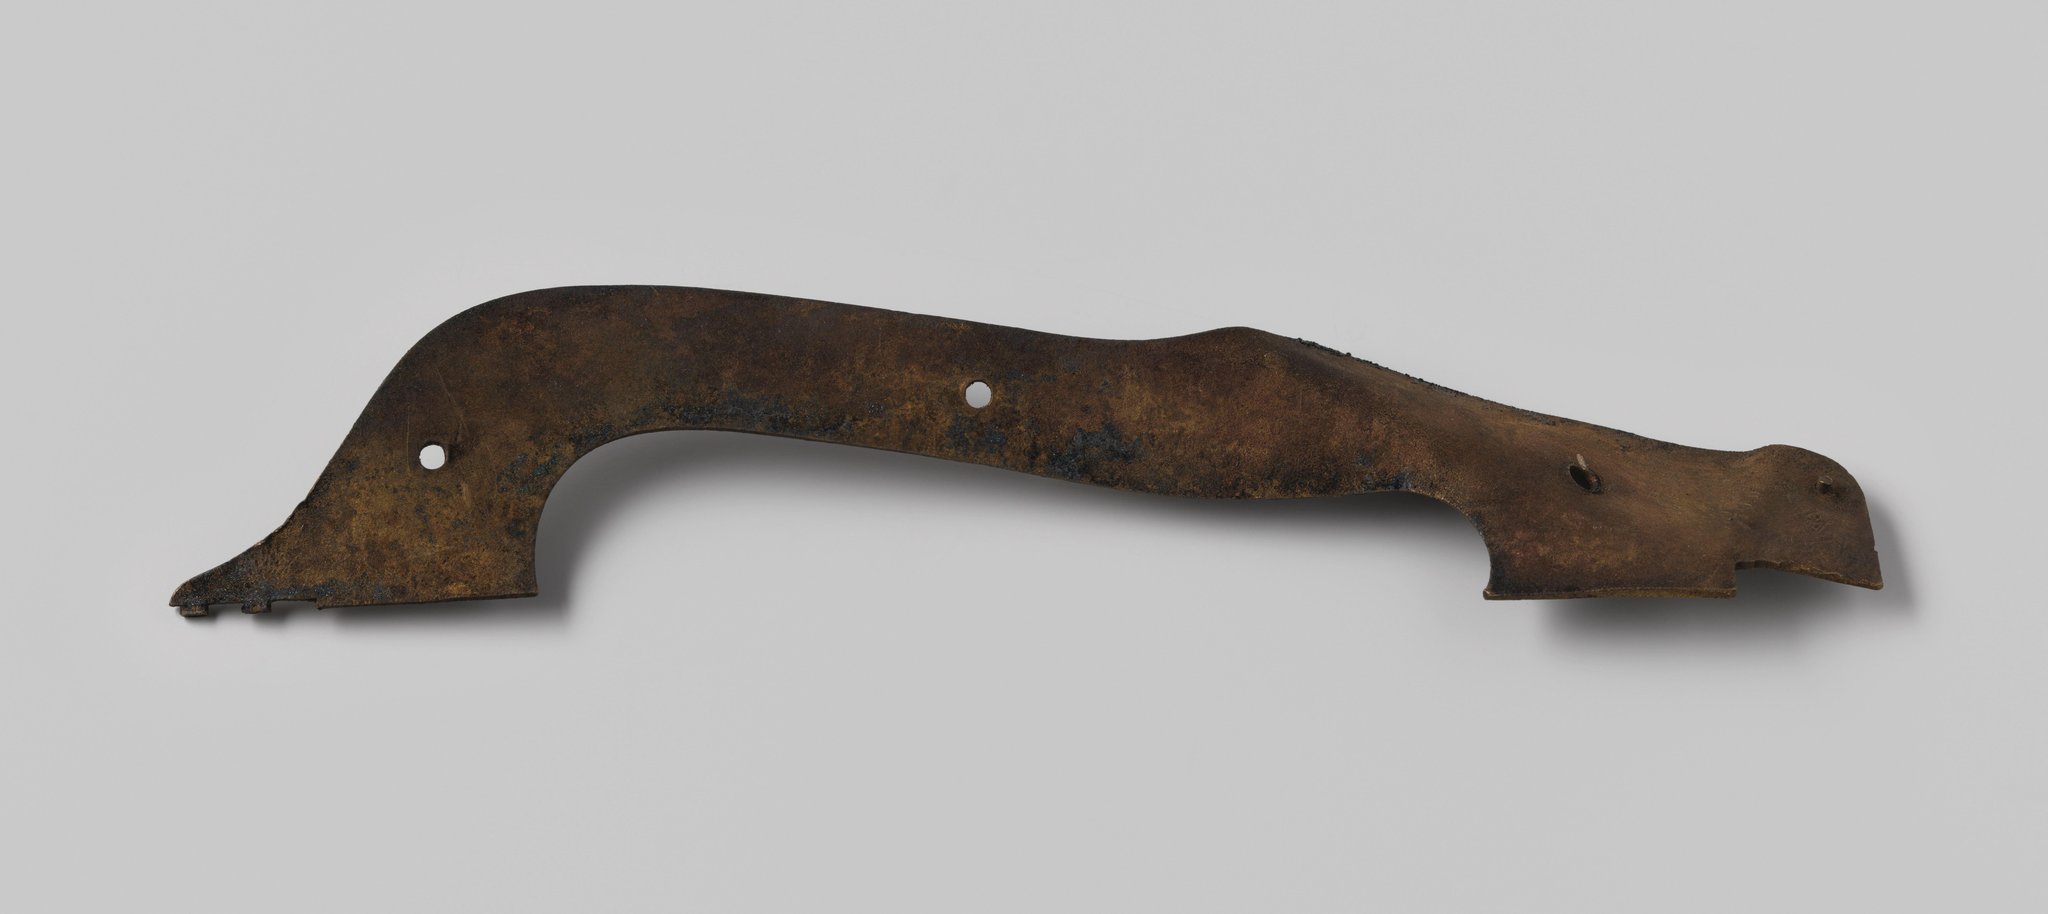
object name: fragment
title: Fragment van koperen beslag uit het wrak van de Oost-Indiëvaarder Hollandia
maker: Anonymous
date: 1700-1743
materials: copper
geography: netherlands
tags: verenigde oostindische compagnie, hollandia (schip), annet